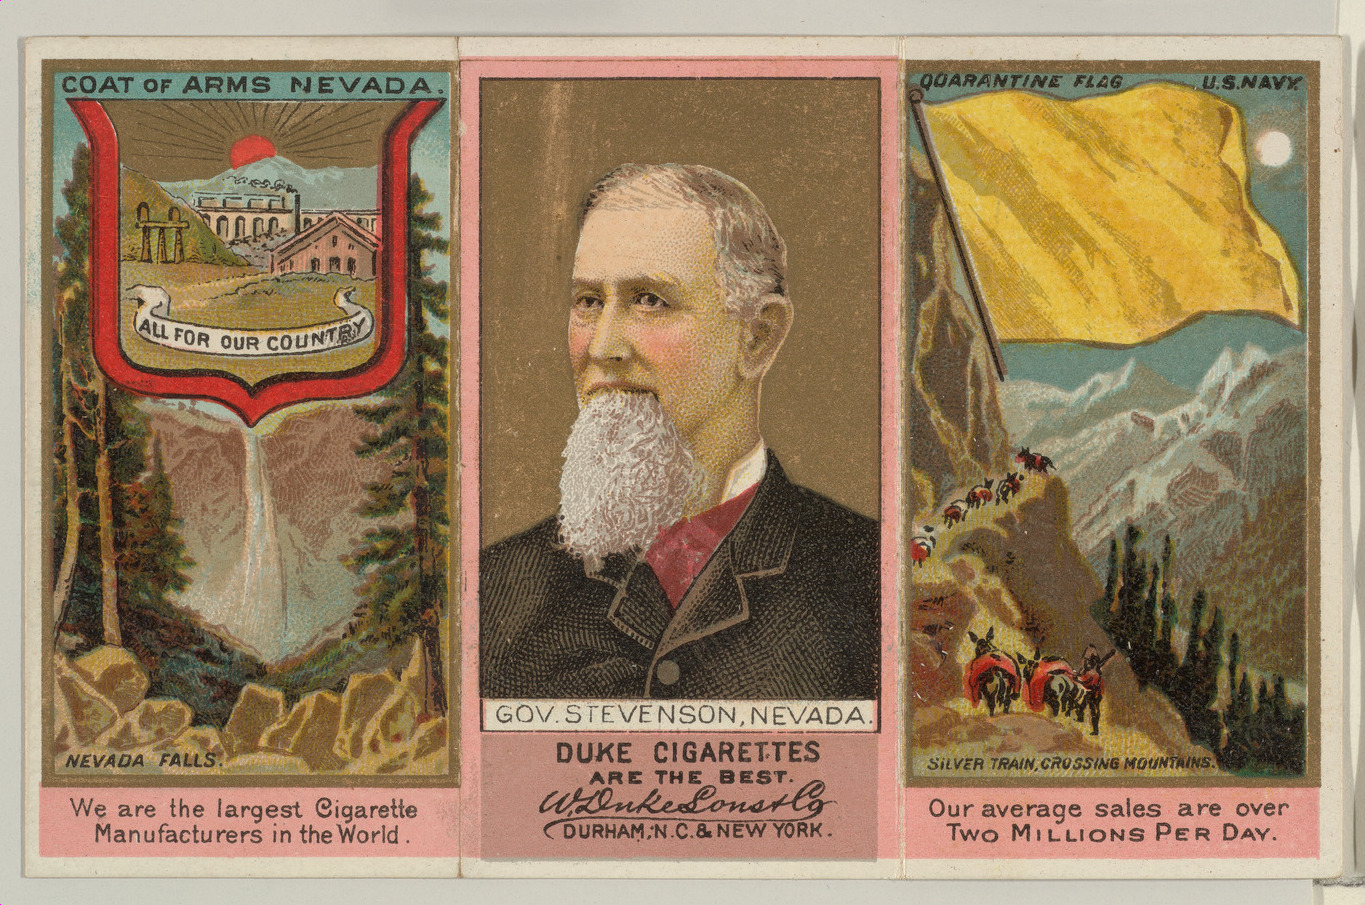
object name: print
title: Governor Stevenson, Nevada, from "Governors, Arms, Etc." series (N133-2), issued by Duke Sons & Co.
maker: w. duke, sons & co.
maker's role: publisher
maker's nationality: american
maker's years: 1870-1920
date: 1888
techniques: color lithograph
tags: men,portraits,coat of arms,flags